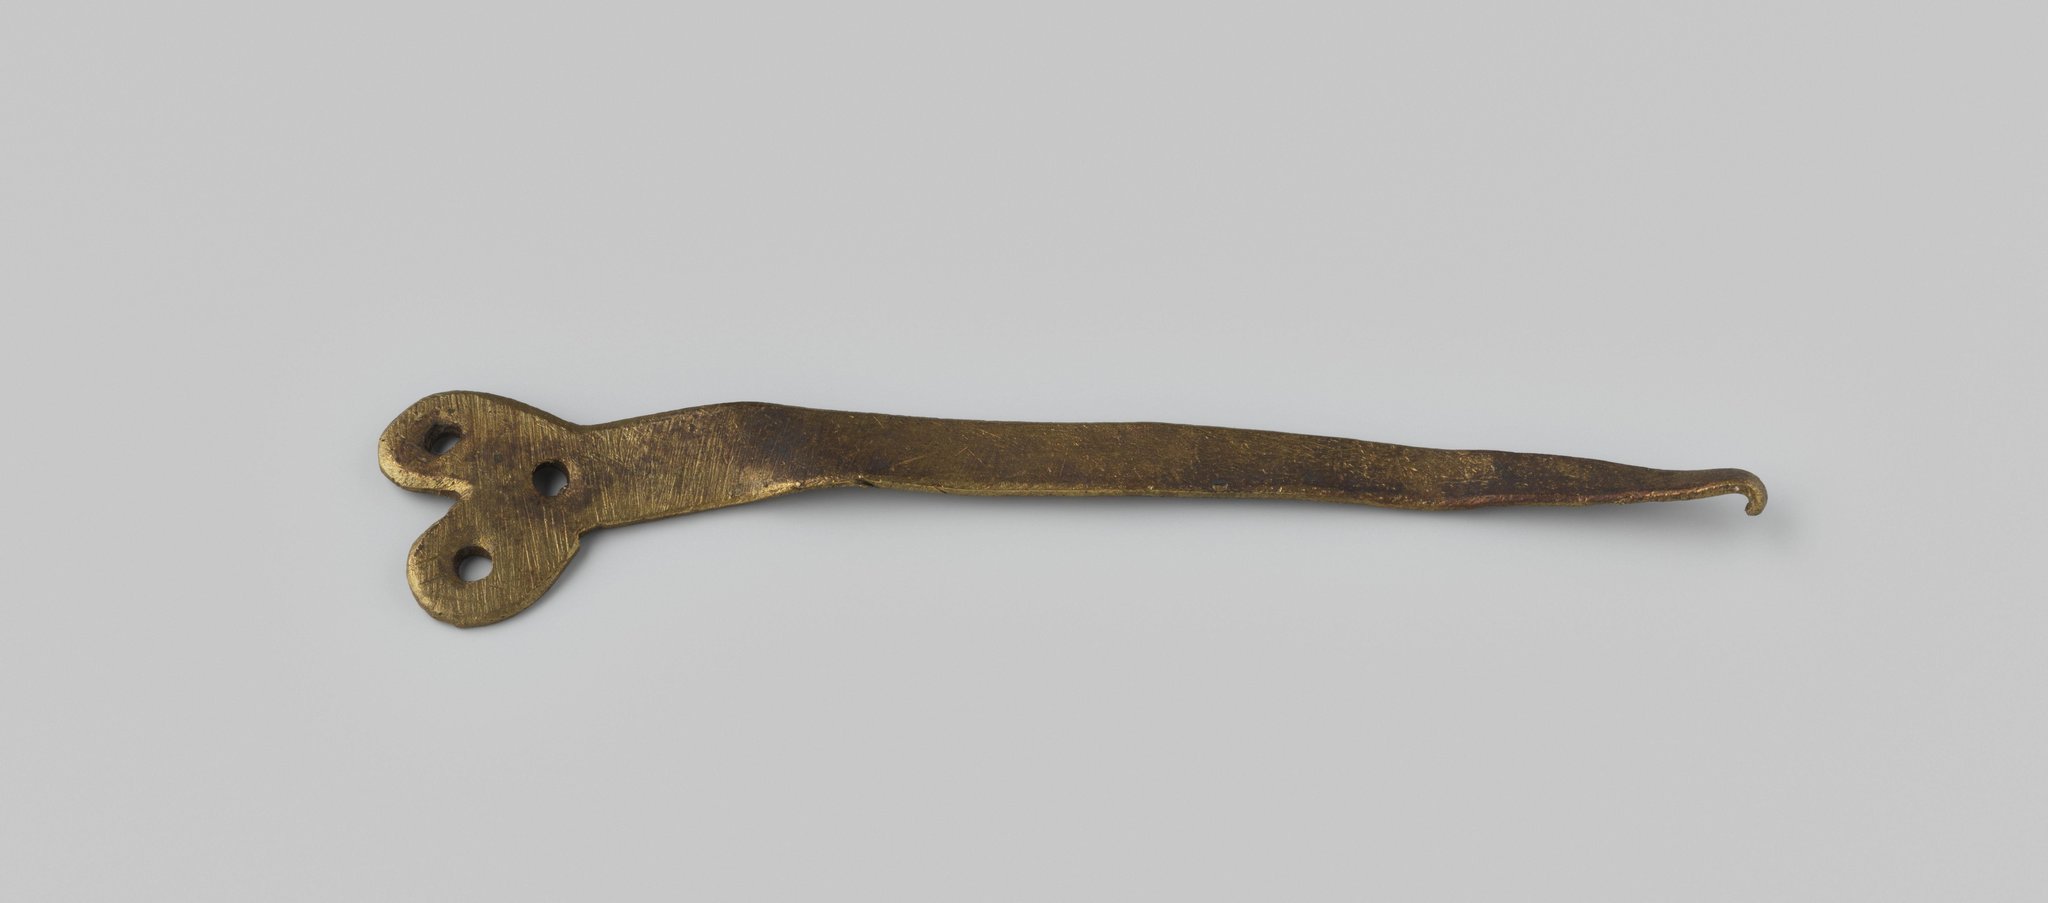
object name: part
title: Onderdeel of hulpstuk afkomstig uit het wrak van de Oost-Indiëvaarder Hollandia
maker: Anonymous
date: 1700-1743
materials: copper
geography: netherlands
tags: verenigde oostindische compagnie, hollandia (schip)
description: Strip-shaped fitting; flat, tapering to a point, other end heart-shaped with 3 circular holes.